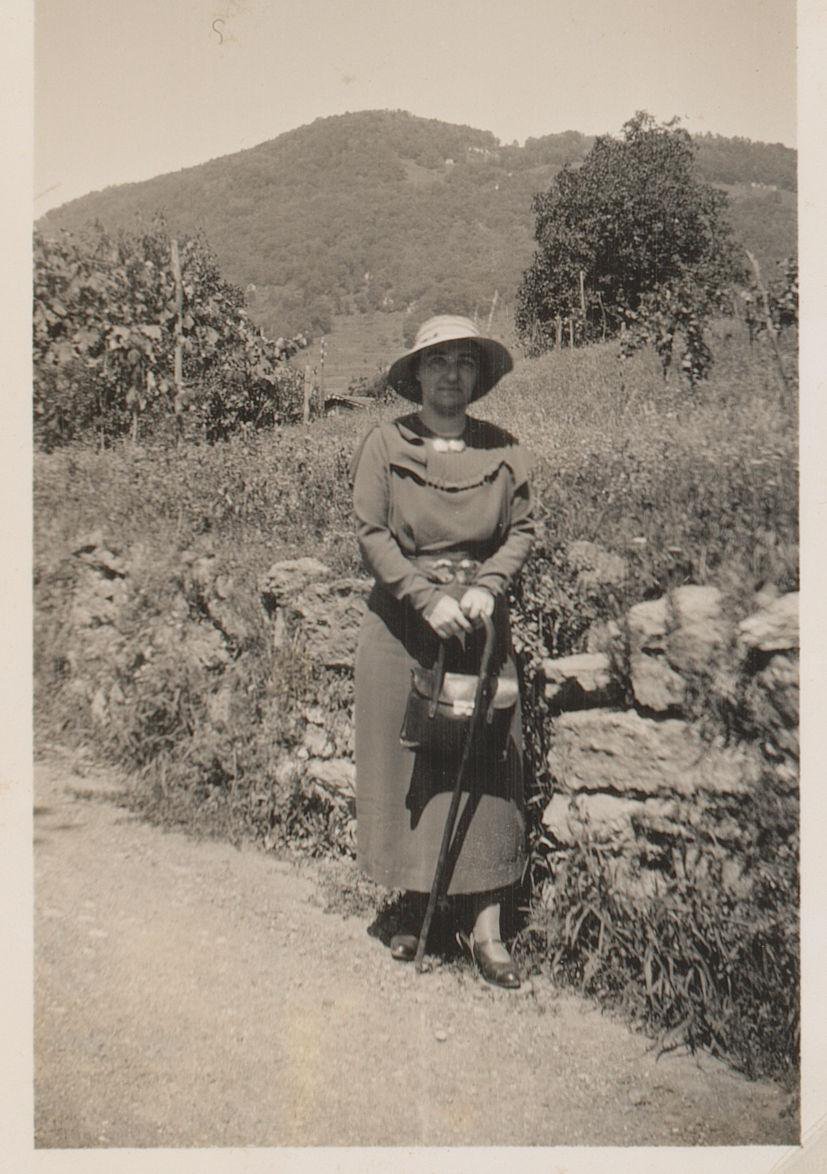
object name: album leaf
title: Vrouw met hoed staande langs een pad nabij Cagiallo, Zwitserland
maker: Anonymous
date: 1907-1934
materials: photographic support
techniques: gelatin silver print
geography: cagiallo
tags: low hill country, historical persons - bb - woman, road, path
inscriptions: number: ‘4’